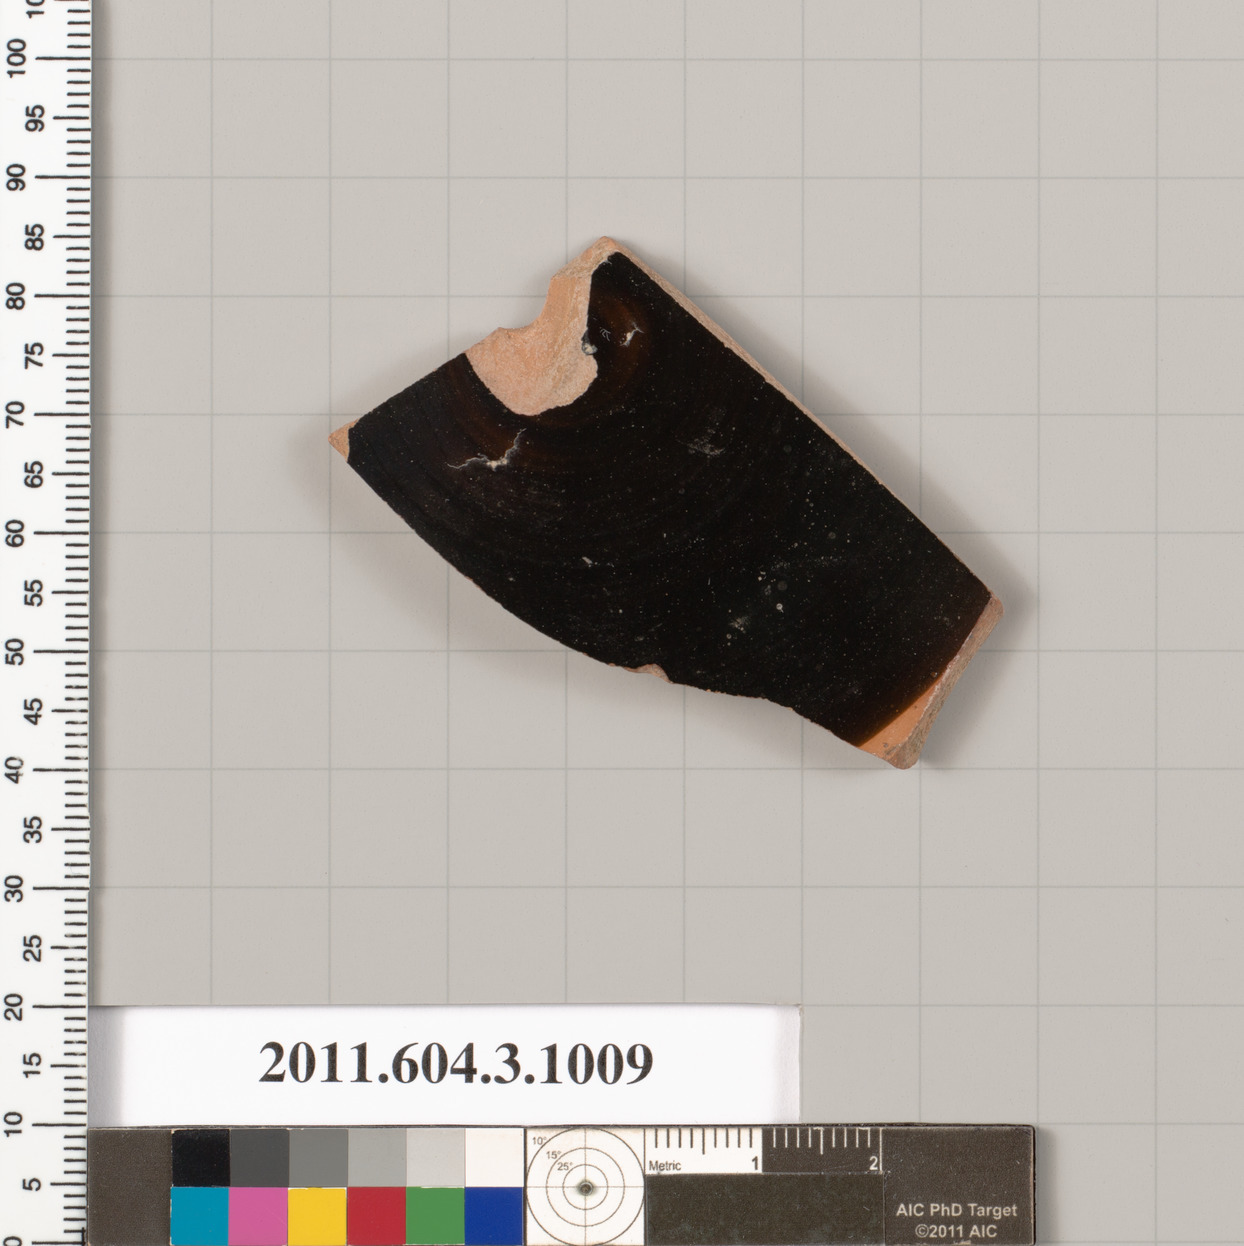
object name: lekanis fragment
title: Terracotta fragment of a lekanis (covered dish)?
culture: greek, attic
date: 600-501 BCE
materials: terracotta